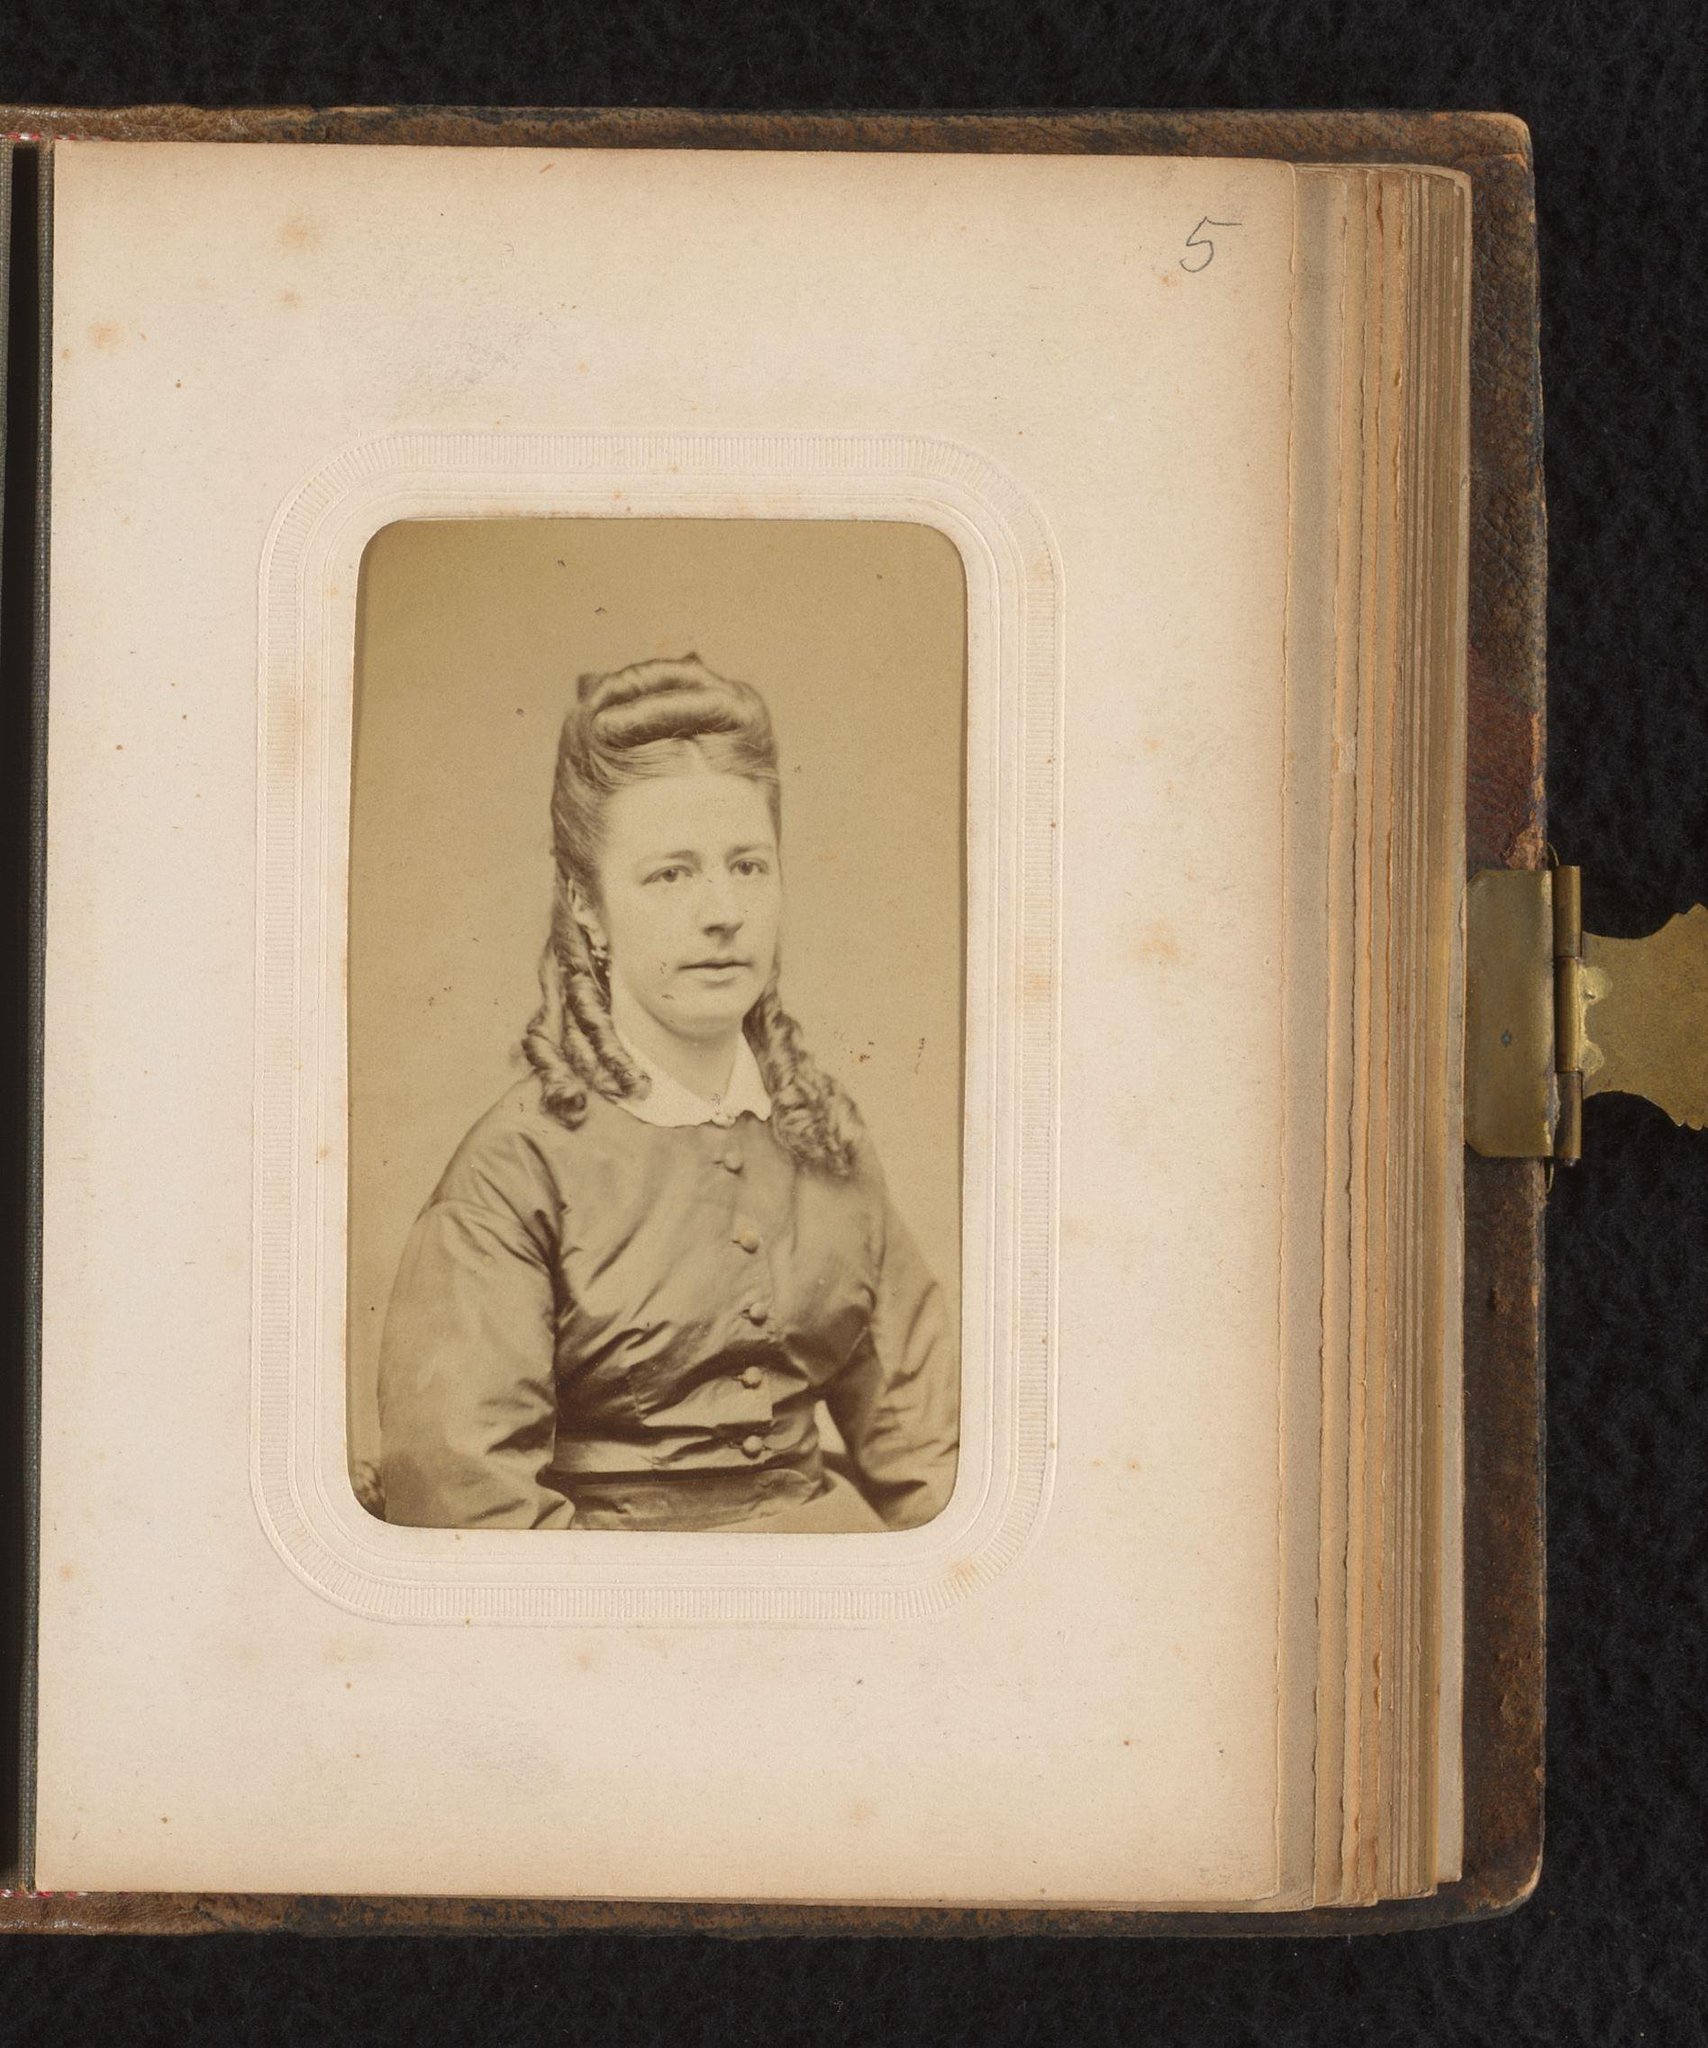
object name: carte de visite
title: Portret van Guurtje van Leijden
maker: louis robert werner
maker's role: fotograaf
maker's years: 1834-1896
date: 1866-1896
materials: cardboard, paper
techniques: albumen print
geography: amsterdam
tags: historical persons - bb - woman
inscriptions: inscription: ‘L.R. Werner/ voorheen/ P. Carstensen/ Nieuwendyk H.150.’, inscription: ‘Guurtje van/ Leyden’